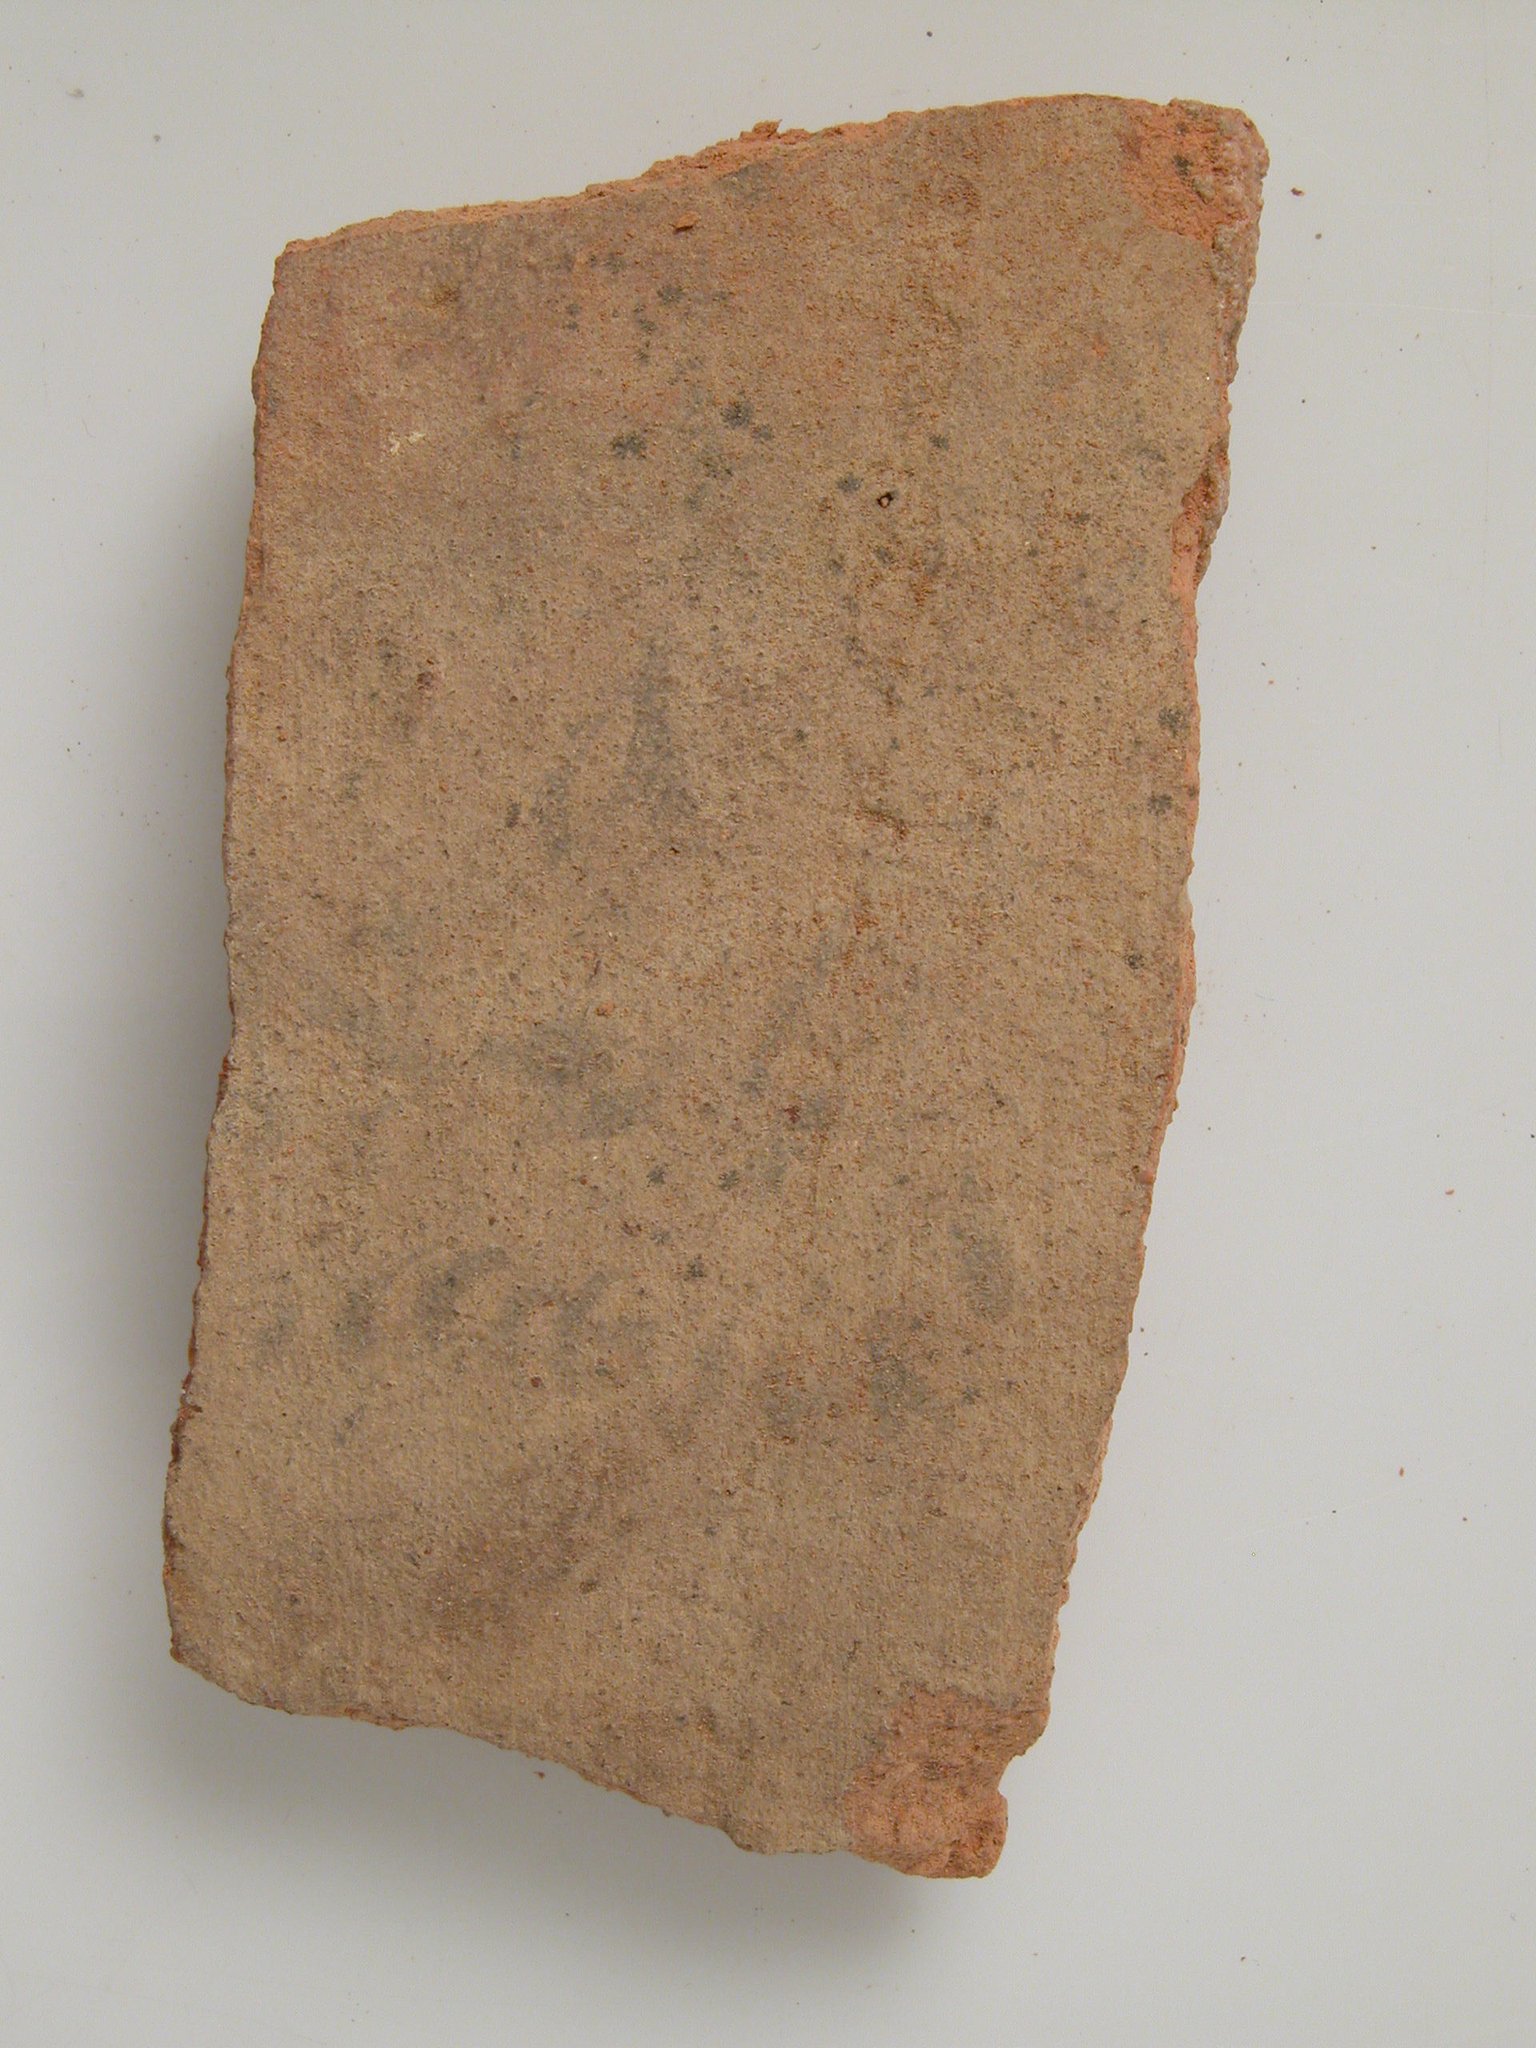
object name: ostracon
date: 400-30 BCE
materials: ink, pottery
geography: egypt